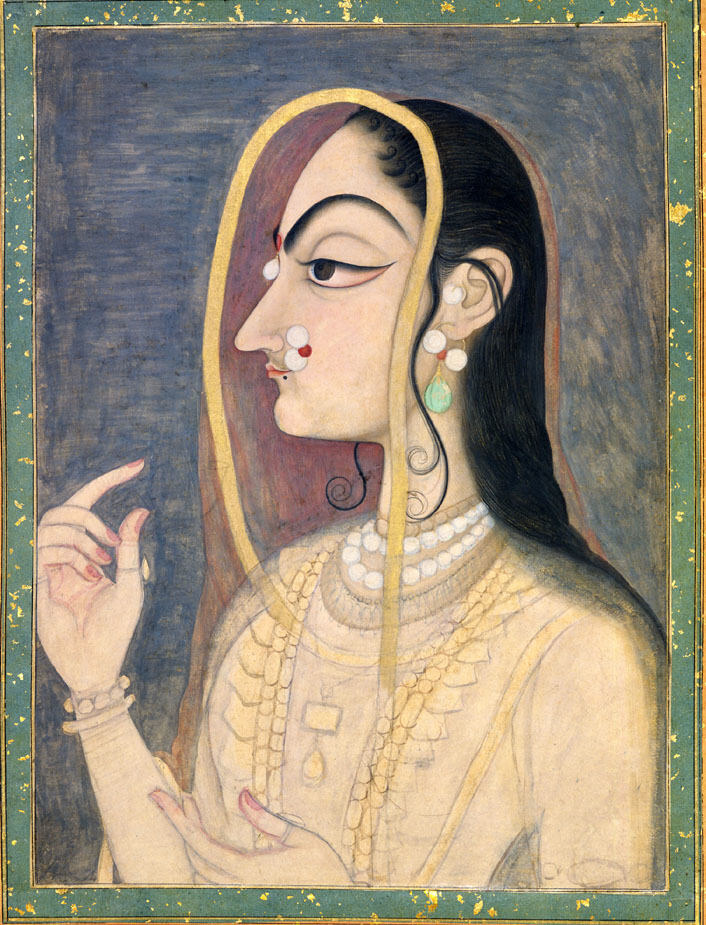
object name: painting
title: Radha, the Beloved of Krishna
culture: indian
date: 1750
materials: ink, paper, watercolor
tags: profiles,women,radha